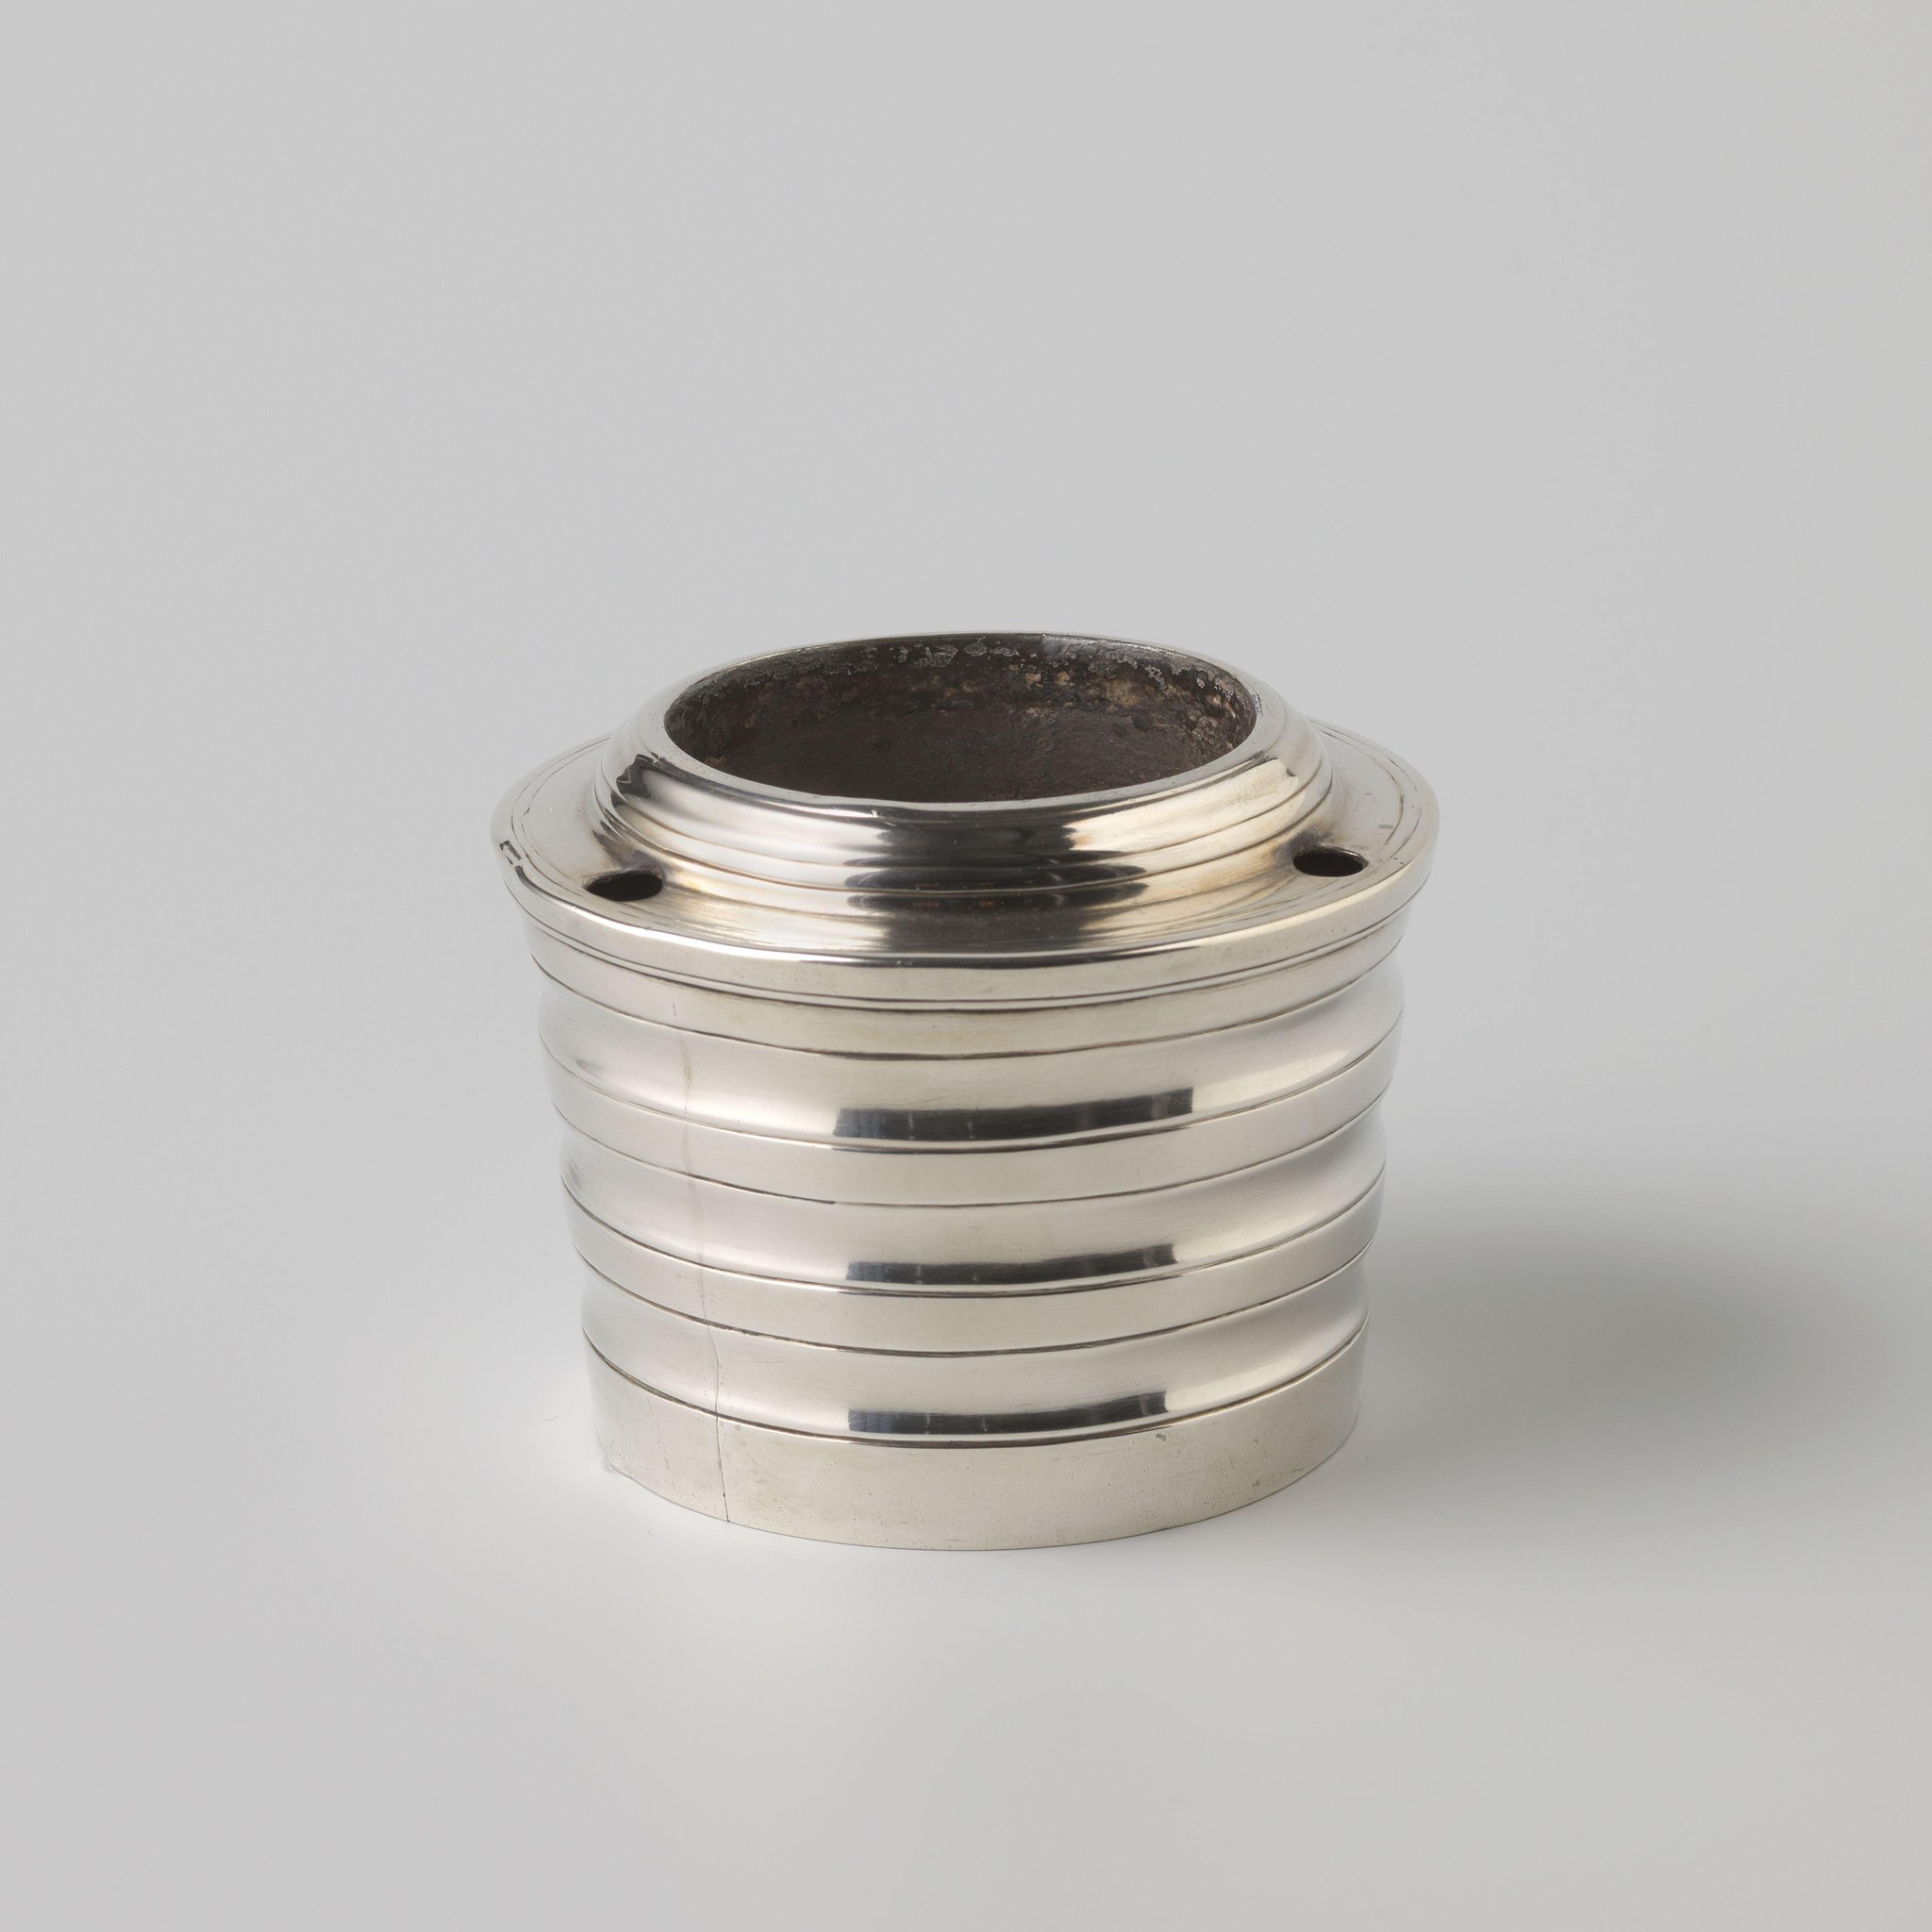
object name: inkstand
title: Inktpot van inktstel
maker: jurriaan van kalker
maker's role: goldsmith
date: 1725-1750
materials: silver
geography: jogjakarta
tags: batavia